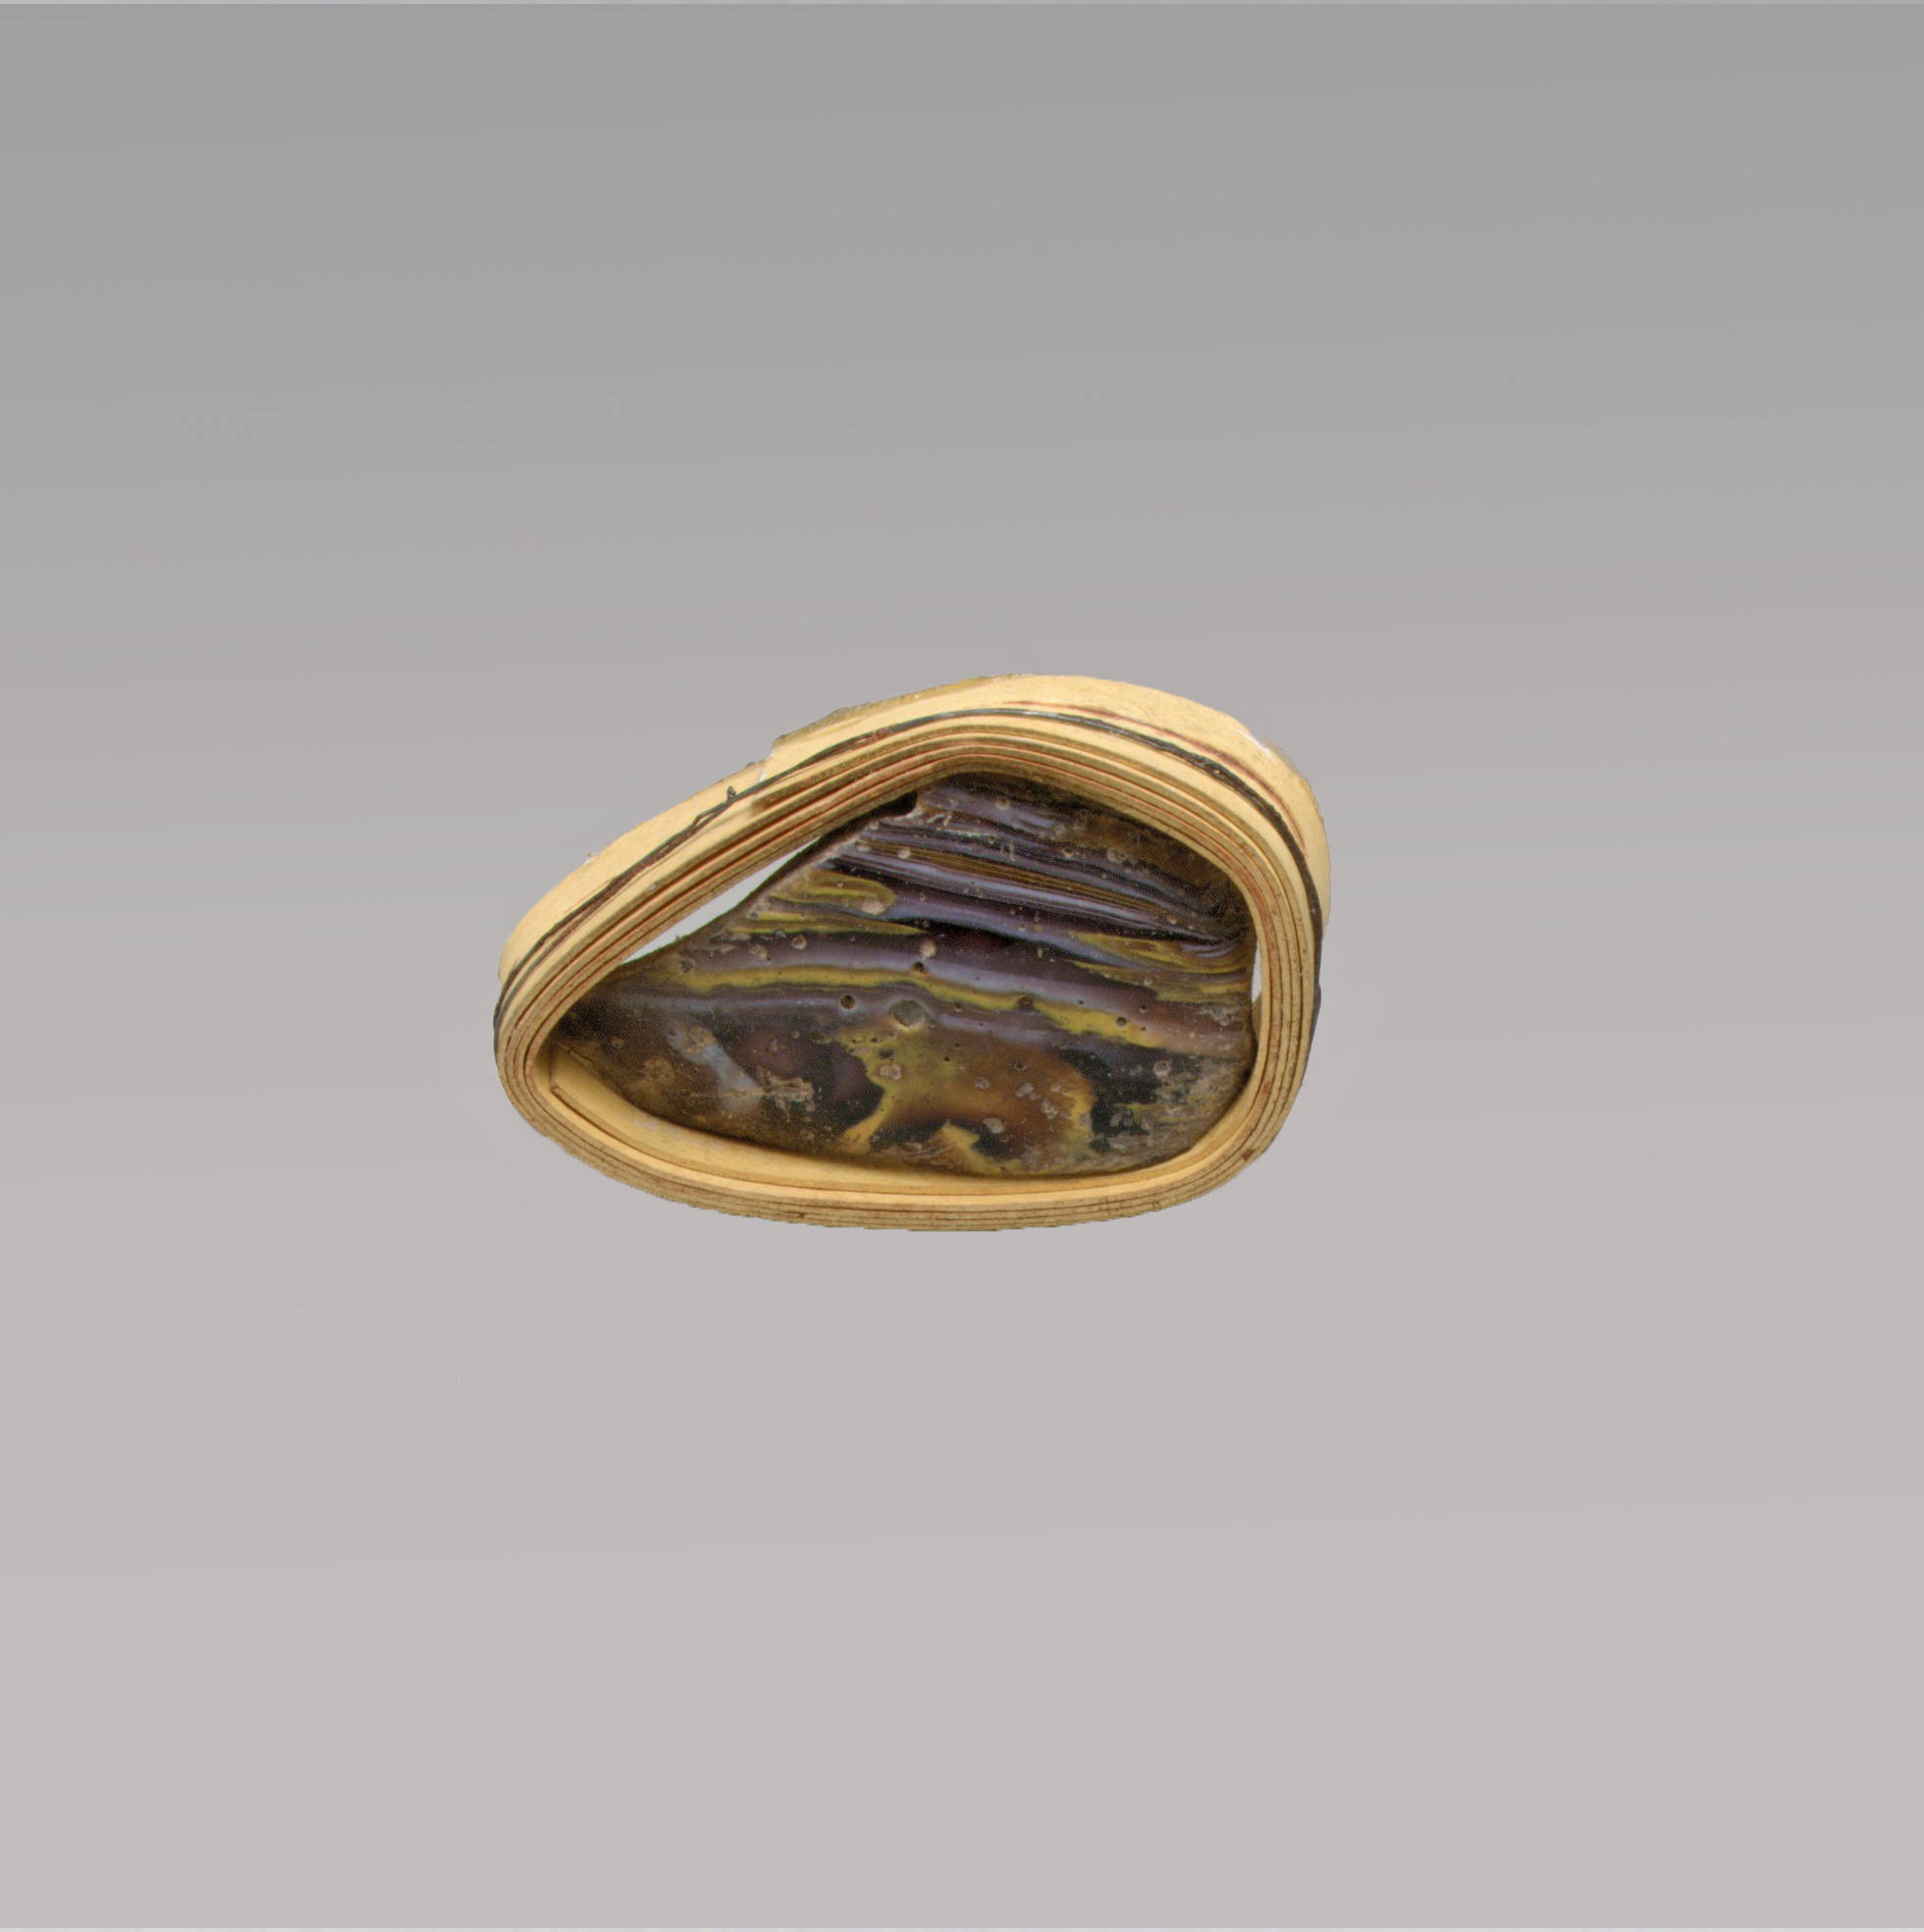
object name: fragment, mosaic bowl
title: Glass mosaic bowl fragment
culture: roman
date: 34 BCE-33 CE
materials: glass